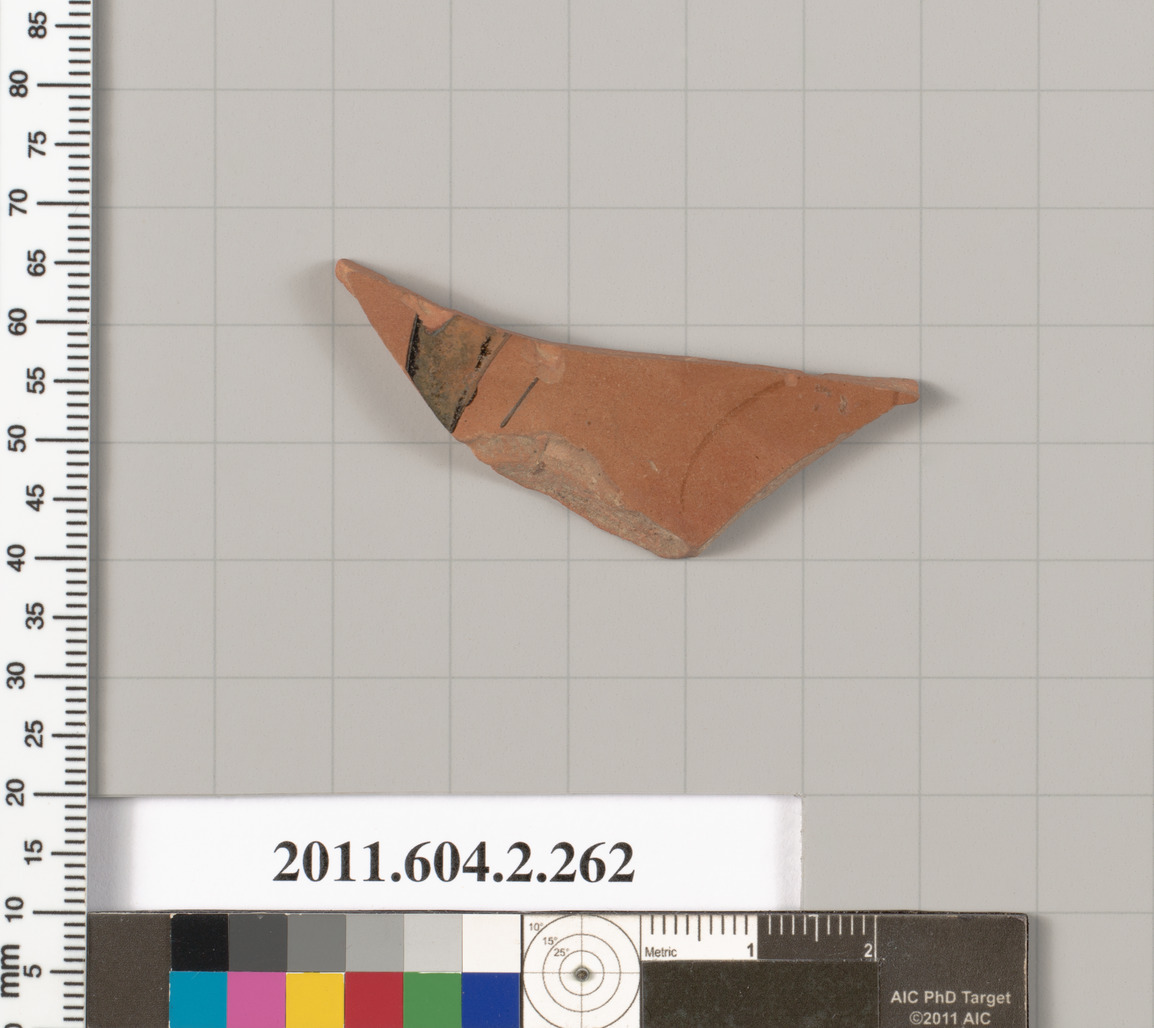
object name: stamnos fragment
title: Terracotta fragment of a stamnos (jar)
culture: greek, attic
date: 490-470 BCE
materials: terracotta